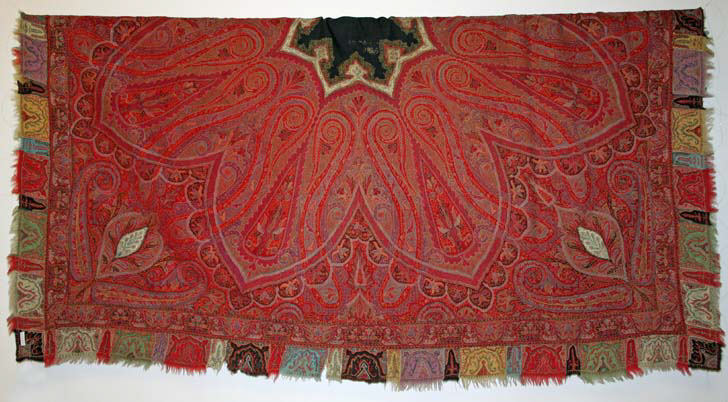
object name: shawl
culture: indian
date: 1801-1900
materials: wool